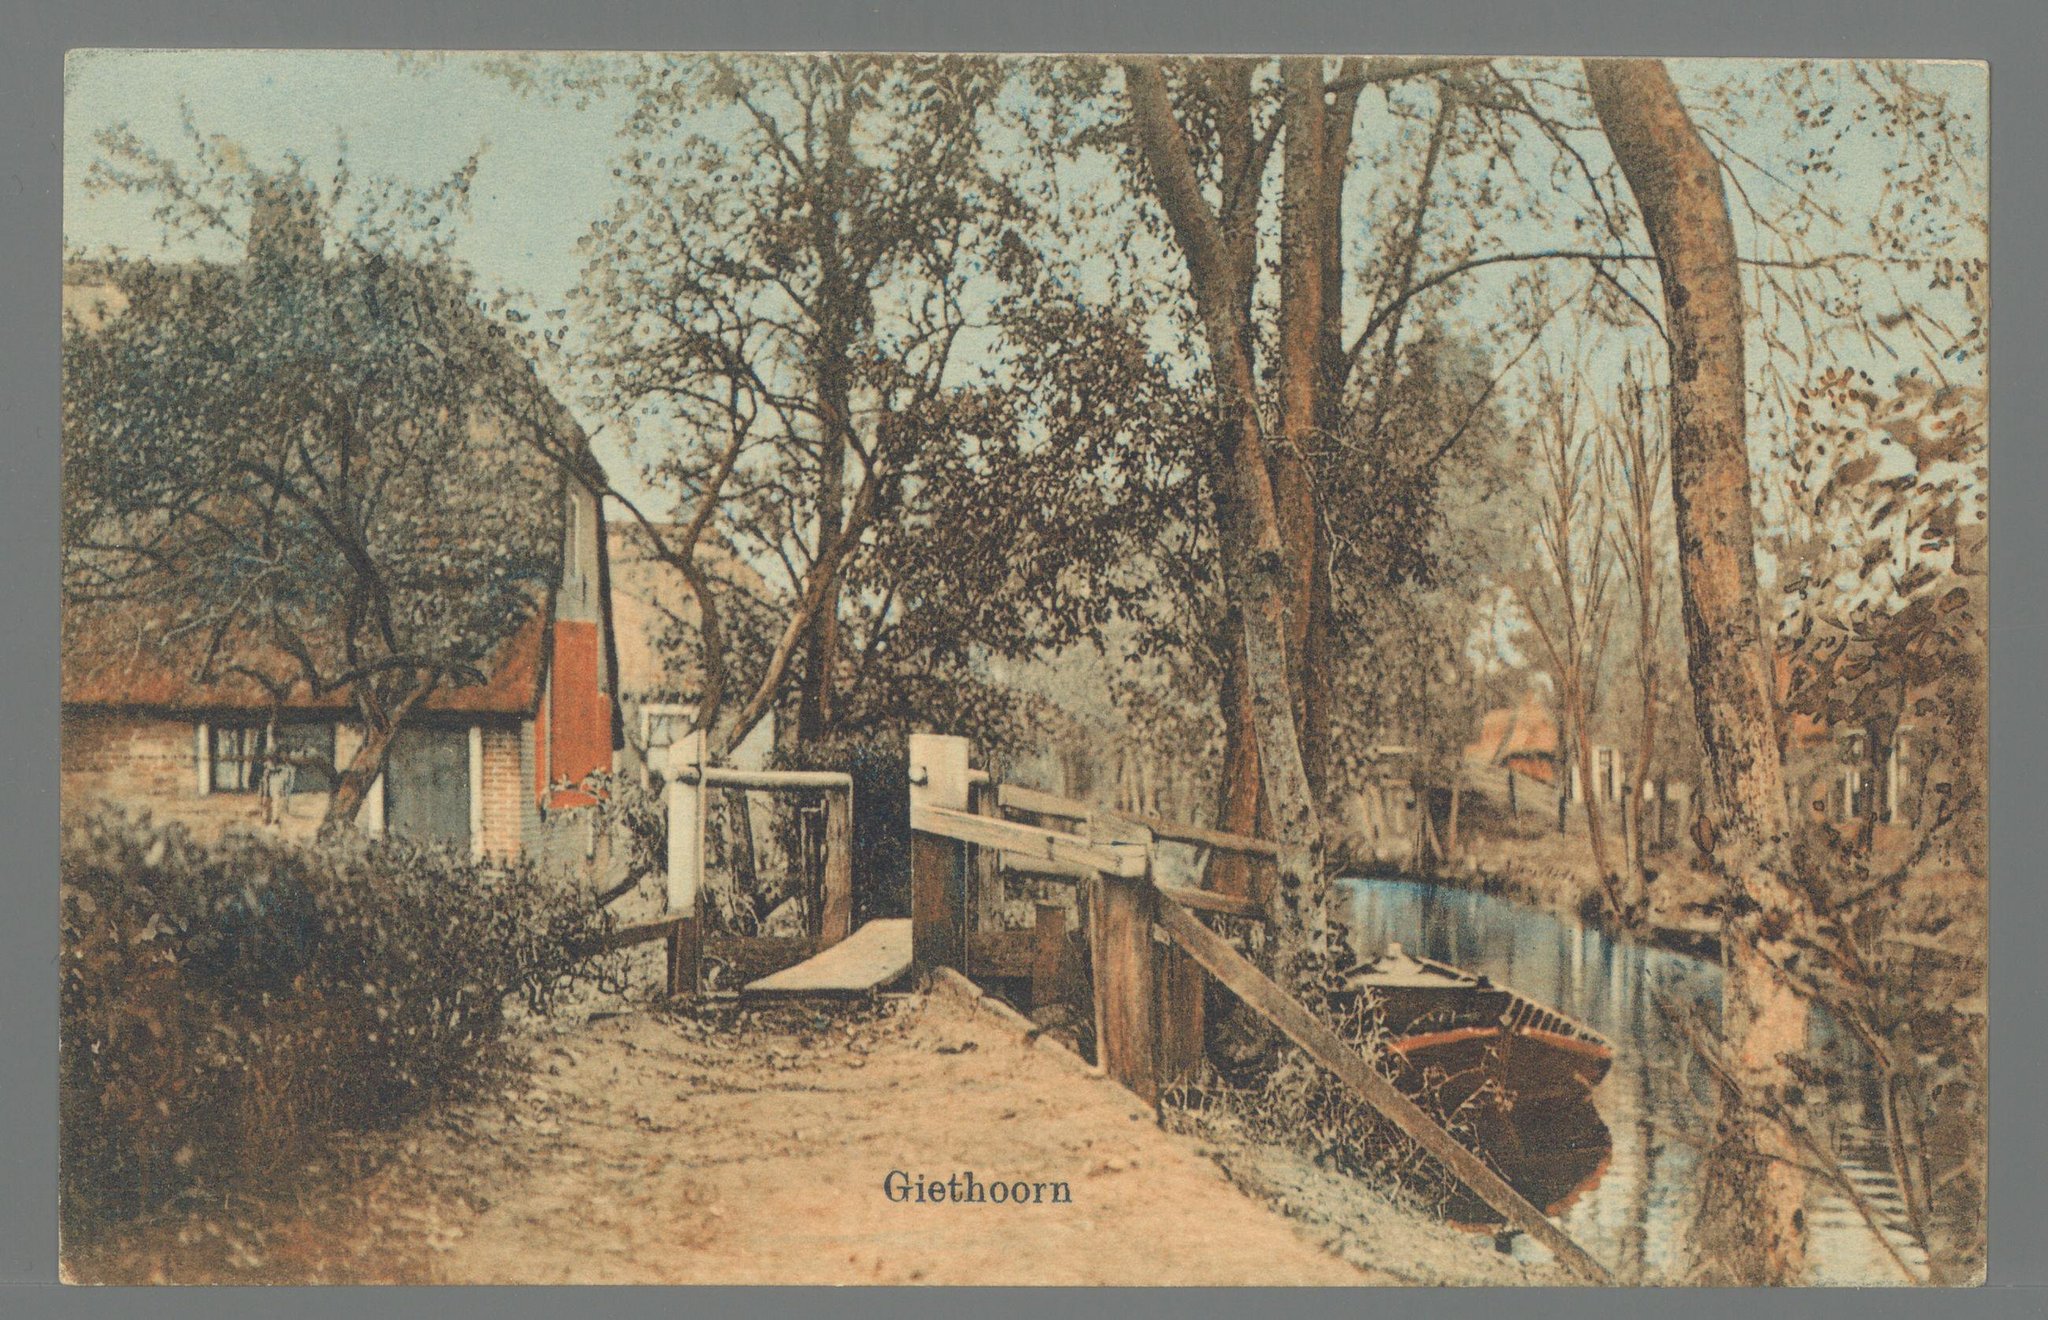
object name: ansichtkaart, prentbriefkaart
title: Giethoorn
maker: Anonymous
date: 1905-1930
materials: cardboard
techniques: collotype process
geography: meppel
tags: canals, waters (in village), housing, bridge in village across river, canal, etc.